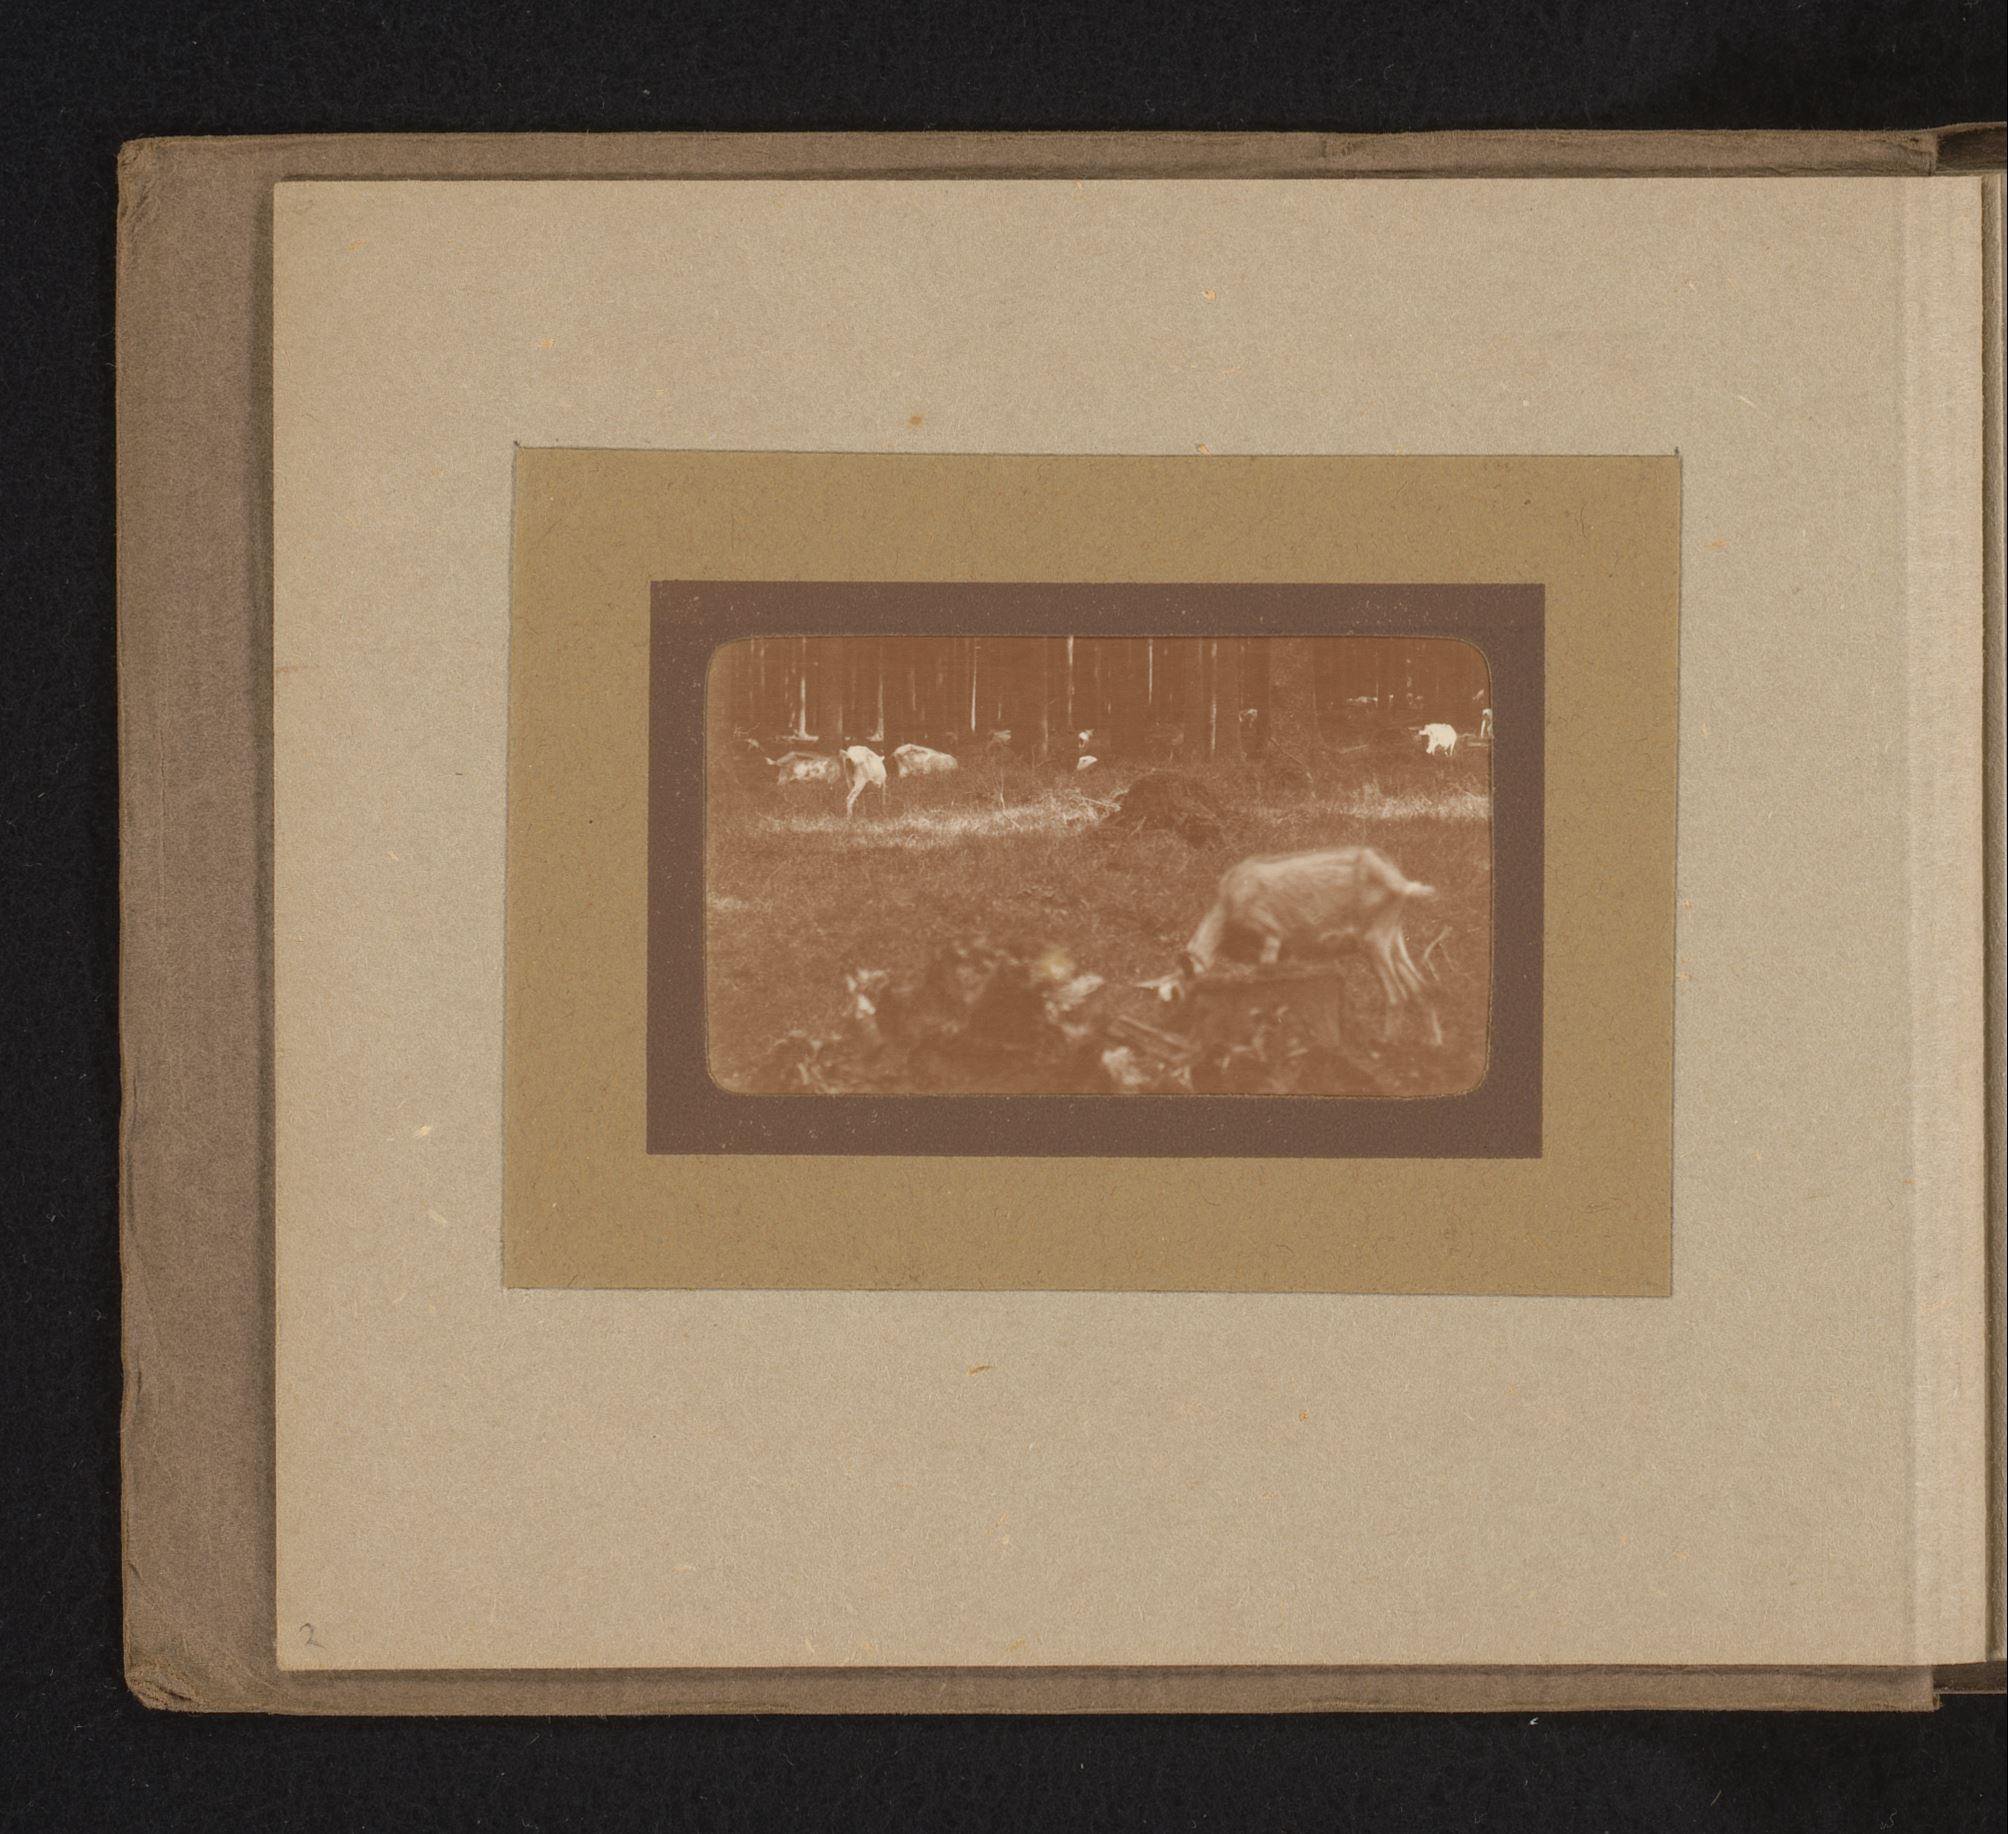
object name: album leaf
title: Dieren in een bos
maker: Anonymous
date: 1900-1930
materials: photographic support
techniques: matte daylight collodion silver print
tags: trees, animals